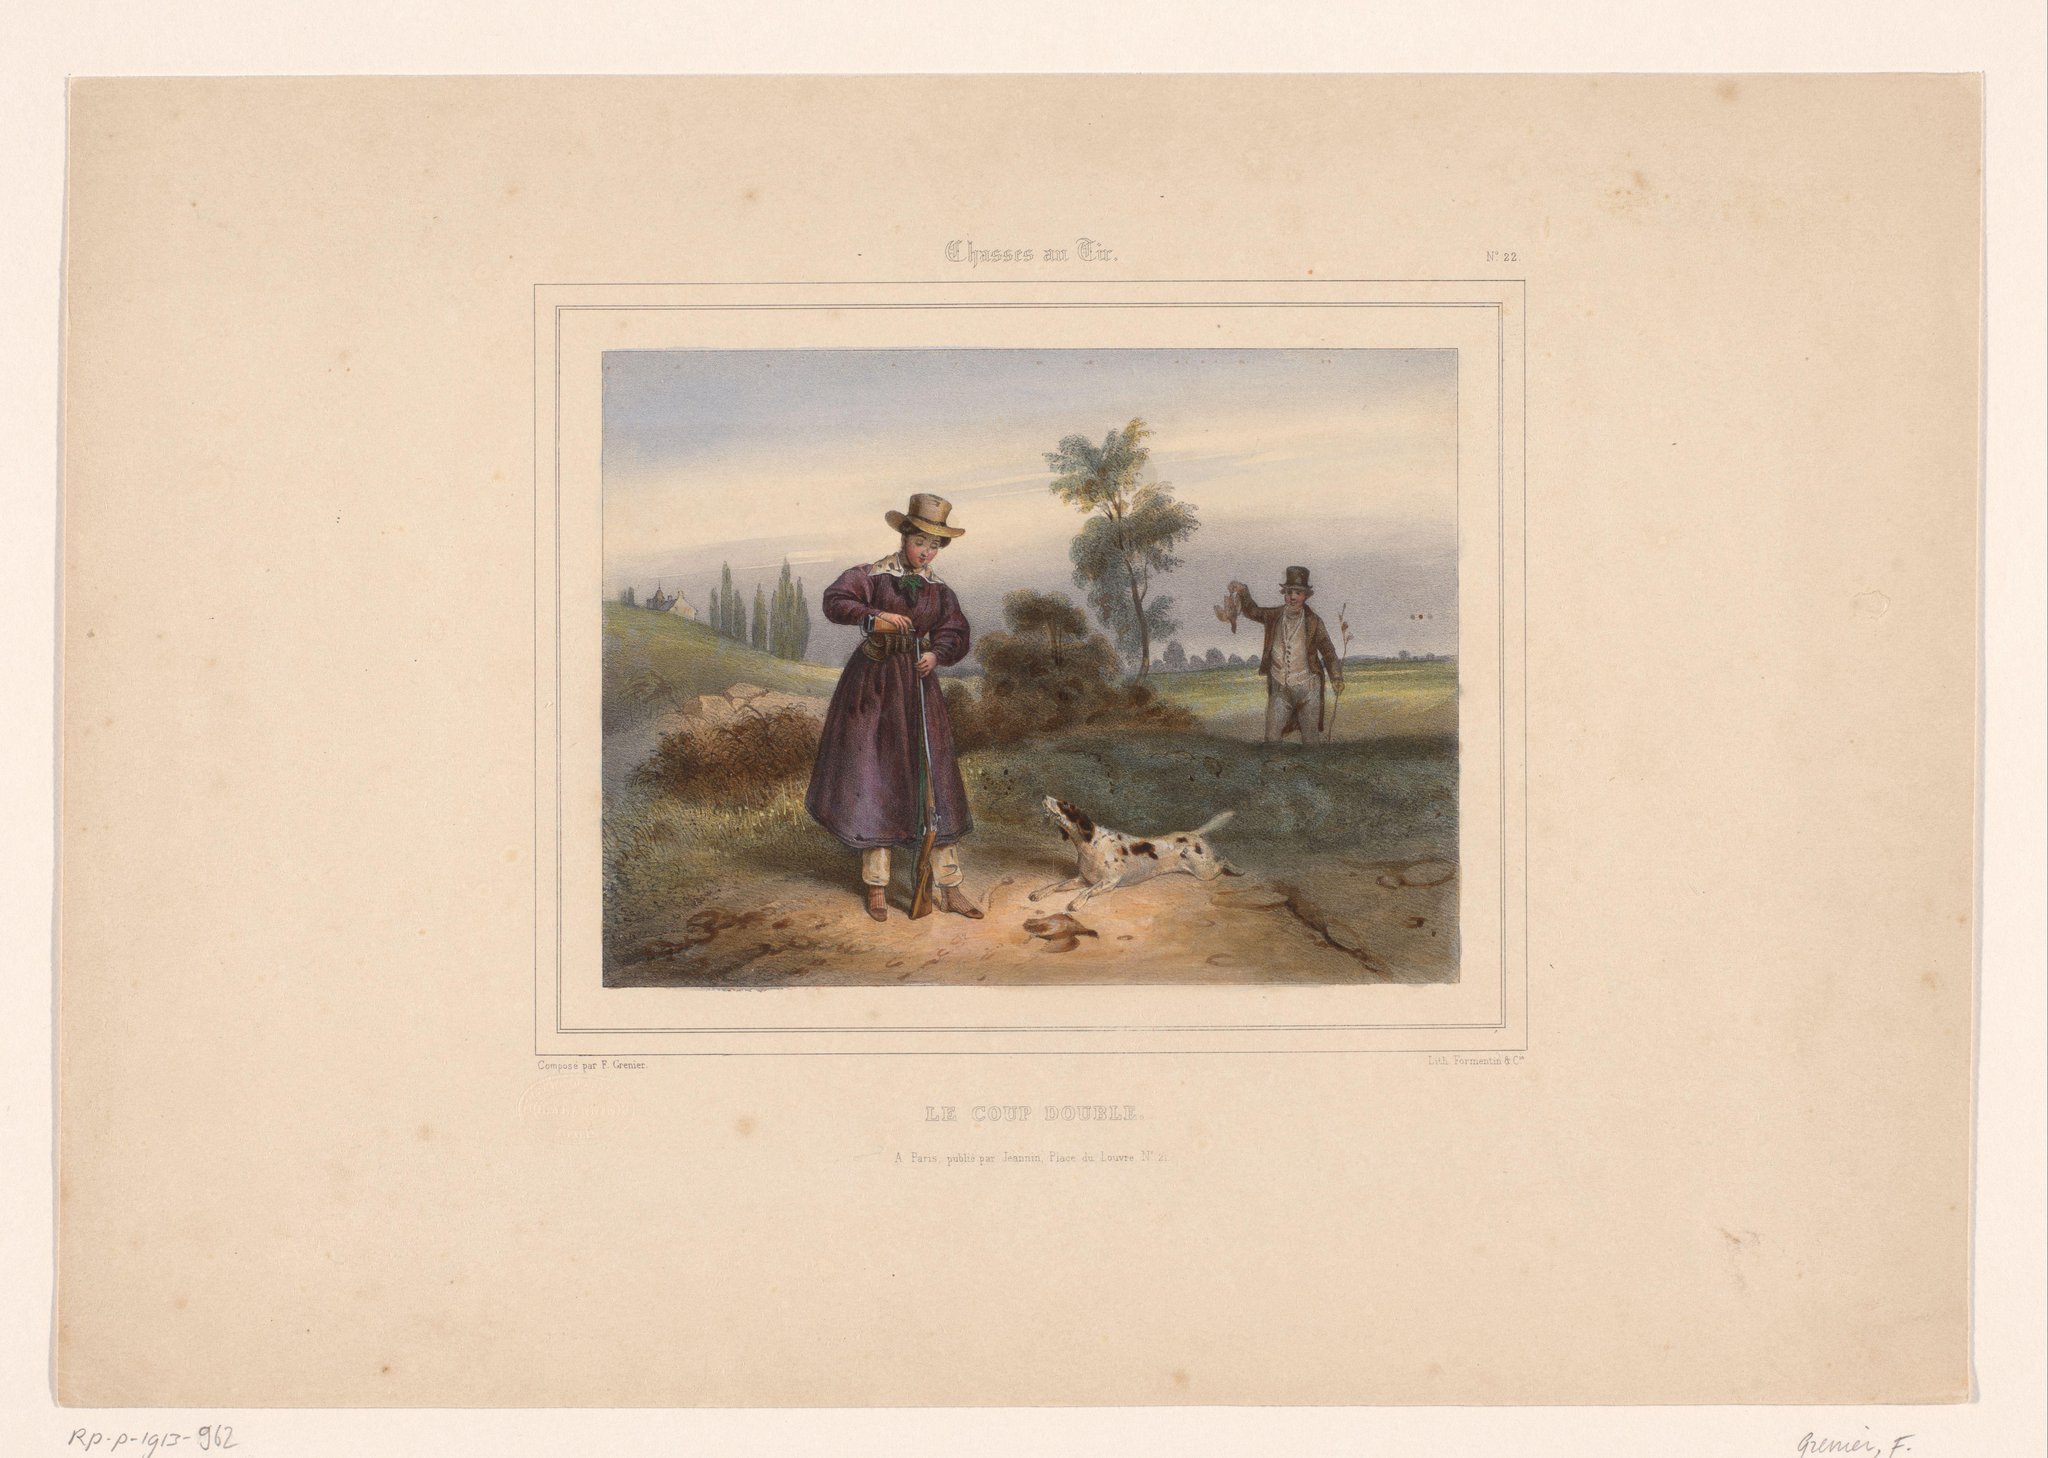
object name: print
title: Jagers met geweren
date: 1831-1846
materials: paper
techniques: hand coloring, lithograph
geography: paris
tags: bird hunting, firearms: rifle, hunter - cc - female hunter, huntress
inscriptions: collector's mark: Lugt 2228a, check stamp: Lugt 1397c